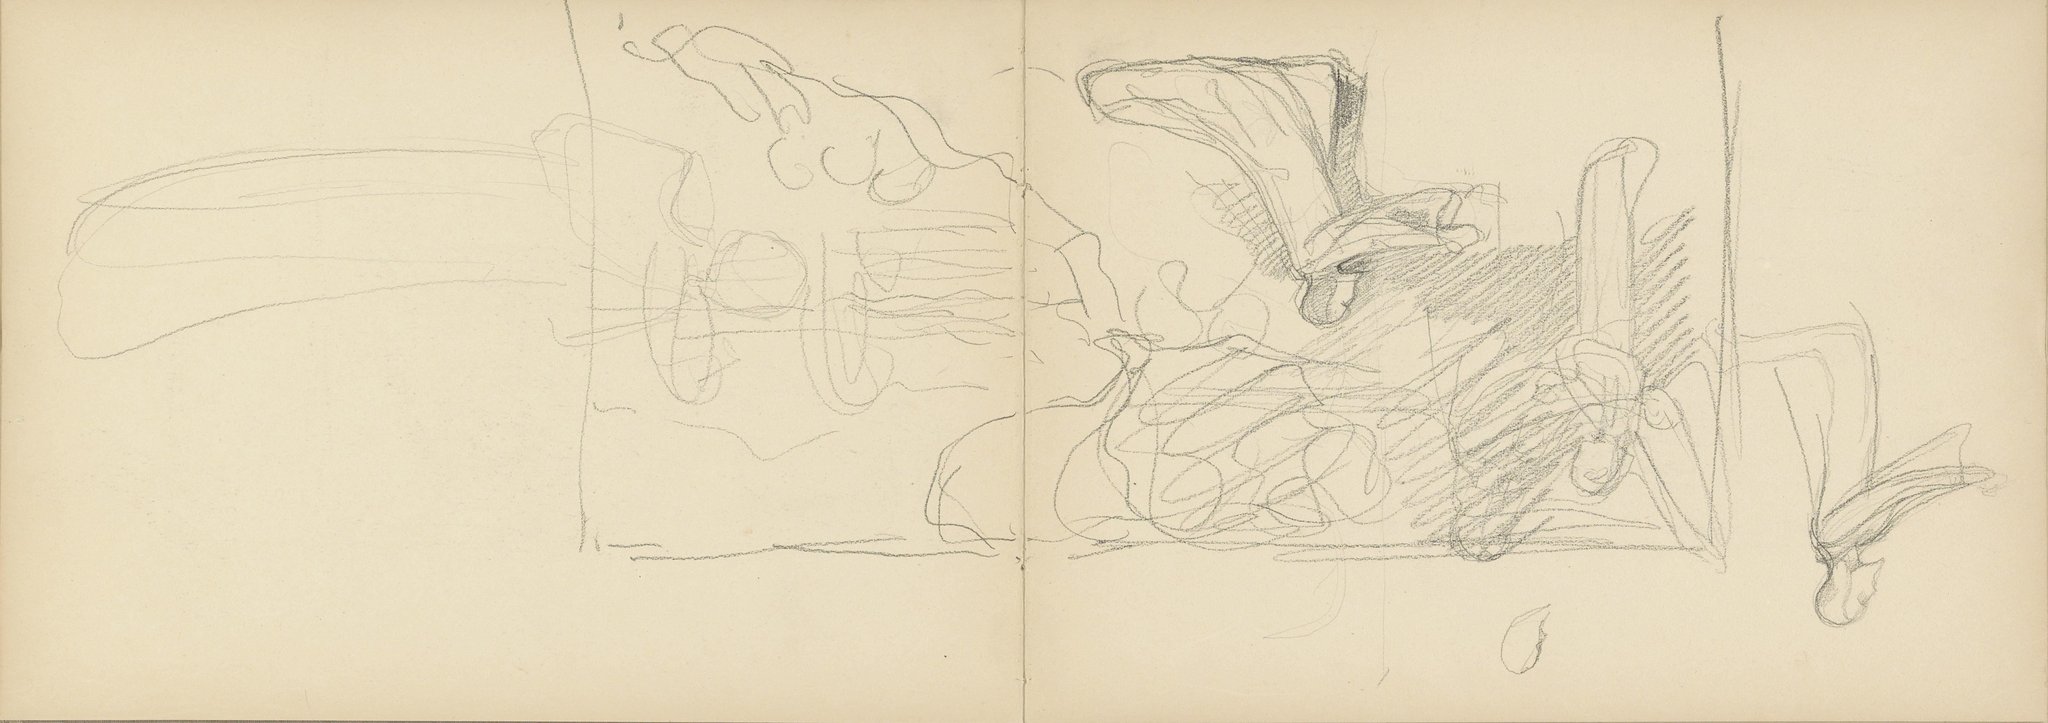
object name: sketchbook leaf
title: Knielende Christus voor een engel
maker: antoon derkinderen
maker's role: draughtsman, painter, print maker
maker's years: 1859-1925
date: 1869-1925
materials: paper, pencil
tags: christ as adult, angels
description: Blad 15 verso en 16 recto uit een schetsboek met 28 bladen.